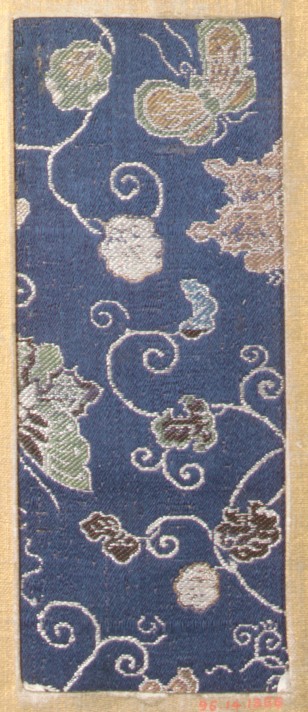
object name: piece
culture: japanese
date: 1701-1900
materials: silk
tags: butterflies